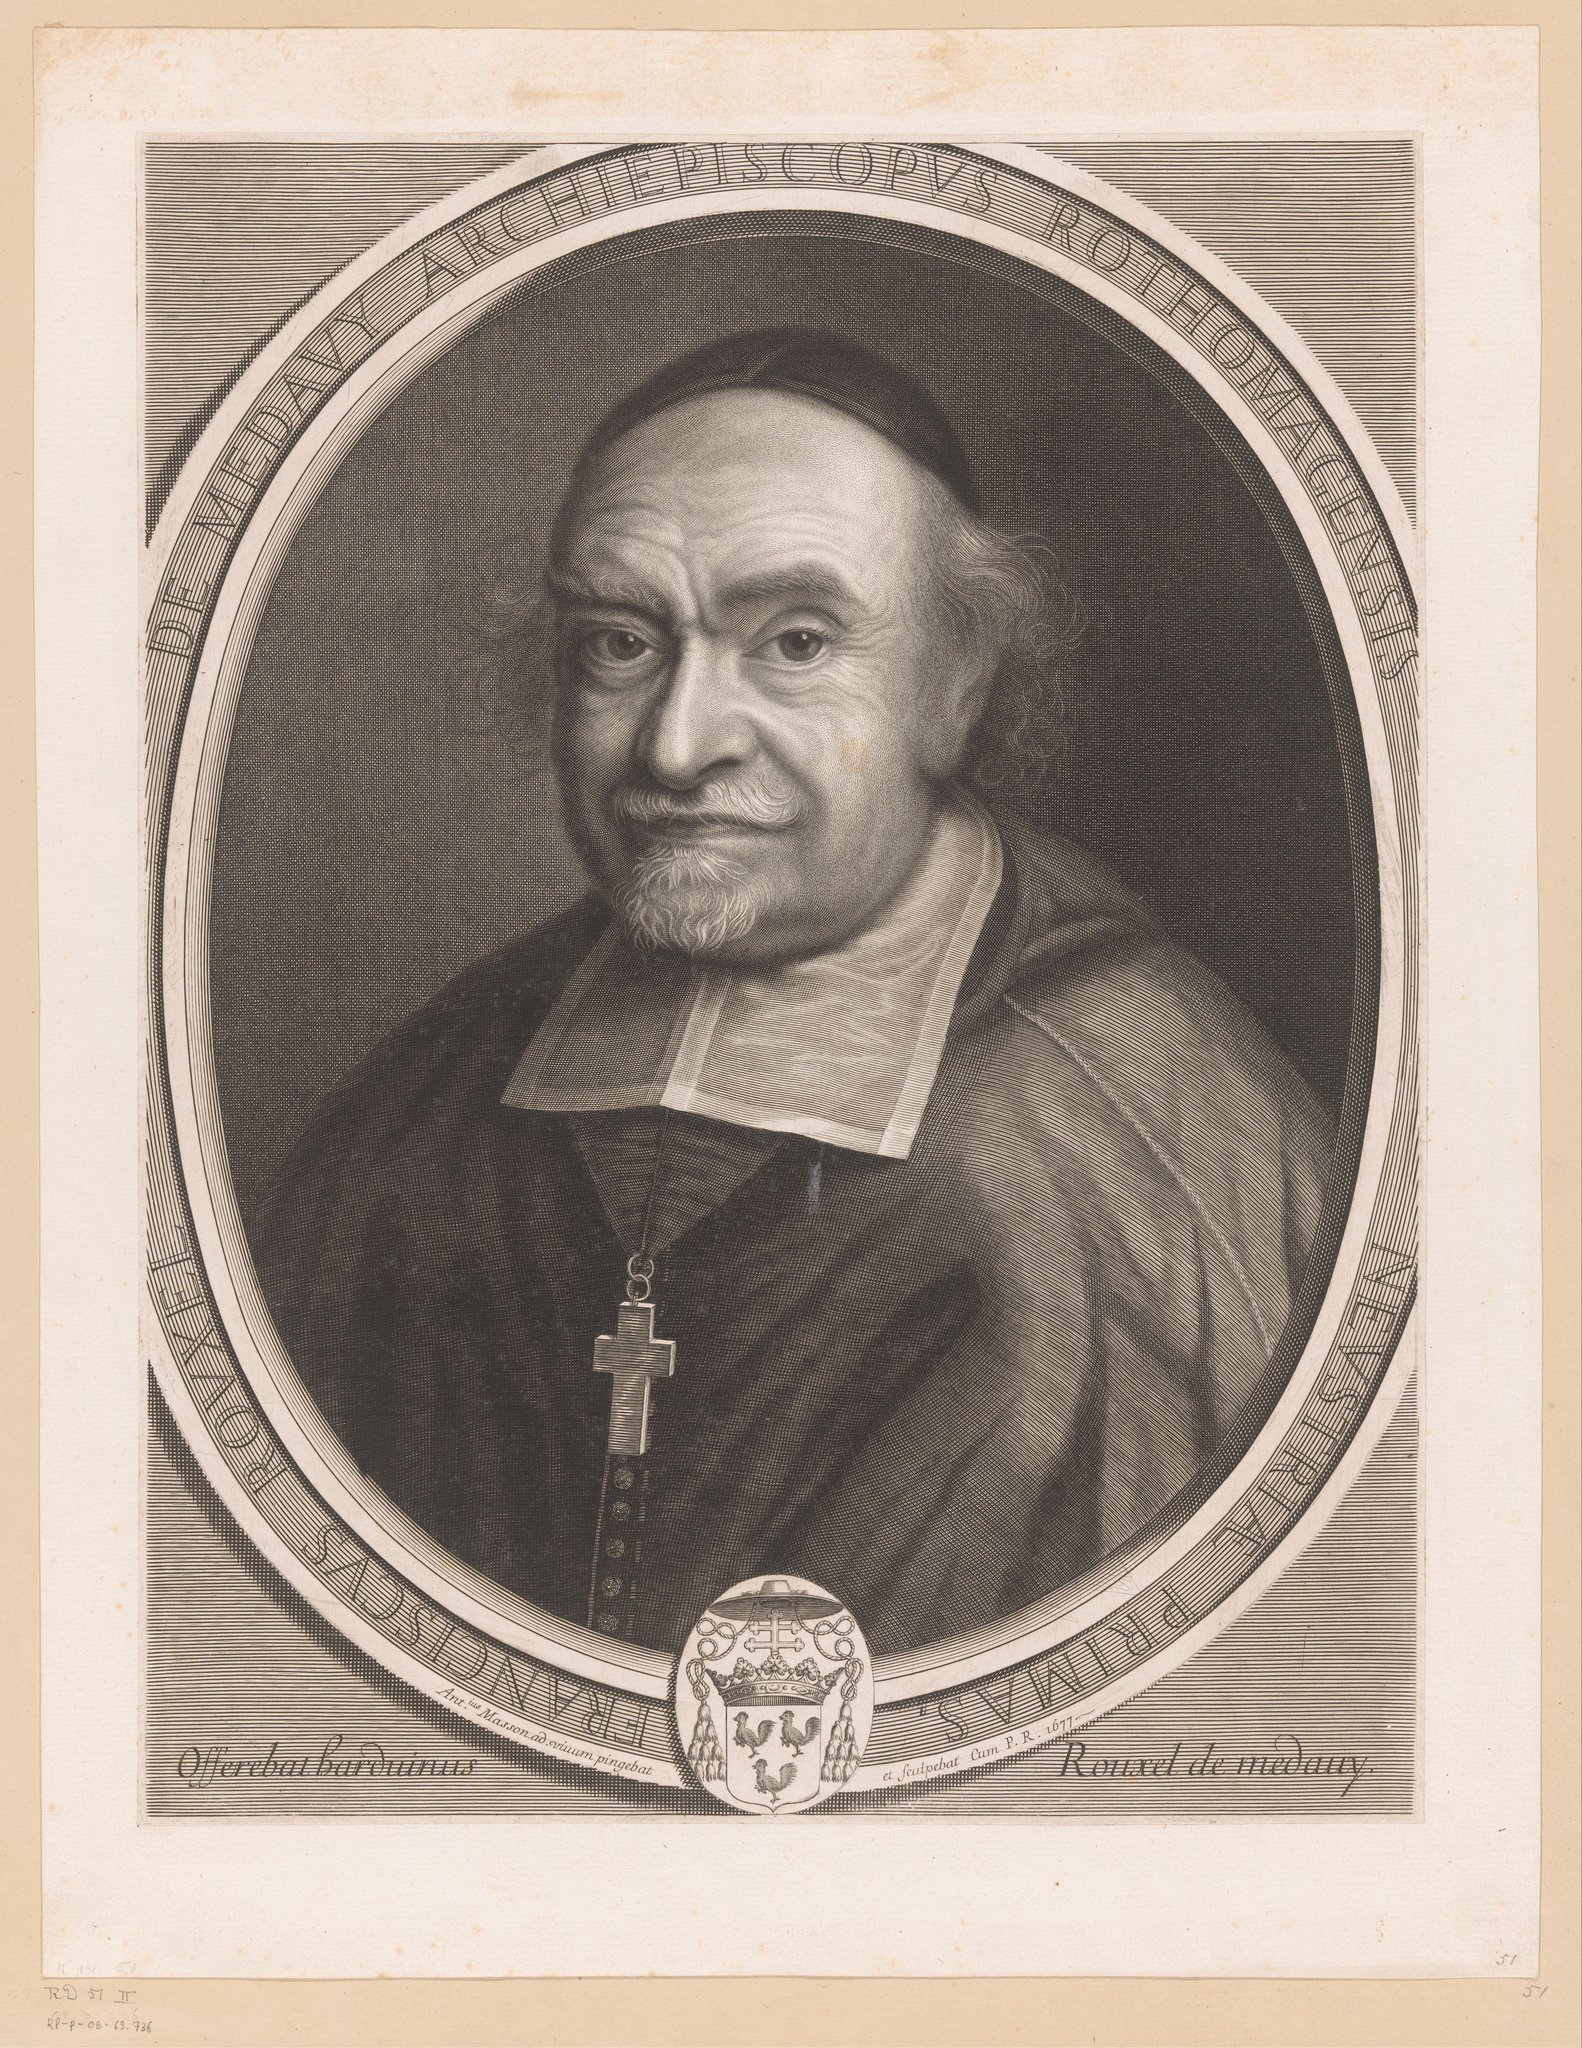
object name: print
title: Portret van François Rouxel de Médavy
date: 1677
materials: paper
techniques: engraving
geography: france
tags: clergyman, françois rouxel de médavy, historical persons, armorial bearing, heraldry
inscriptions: collector's mark: Lugt 240